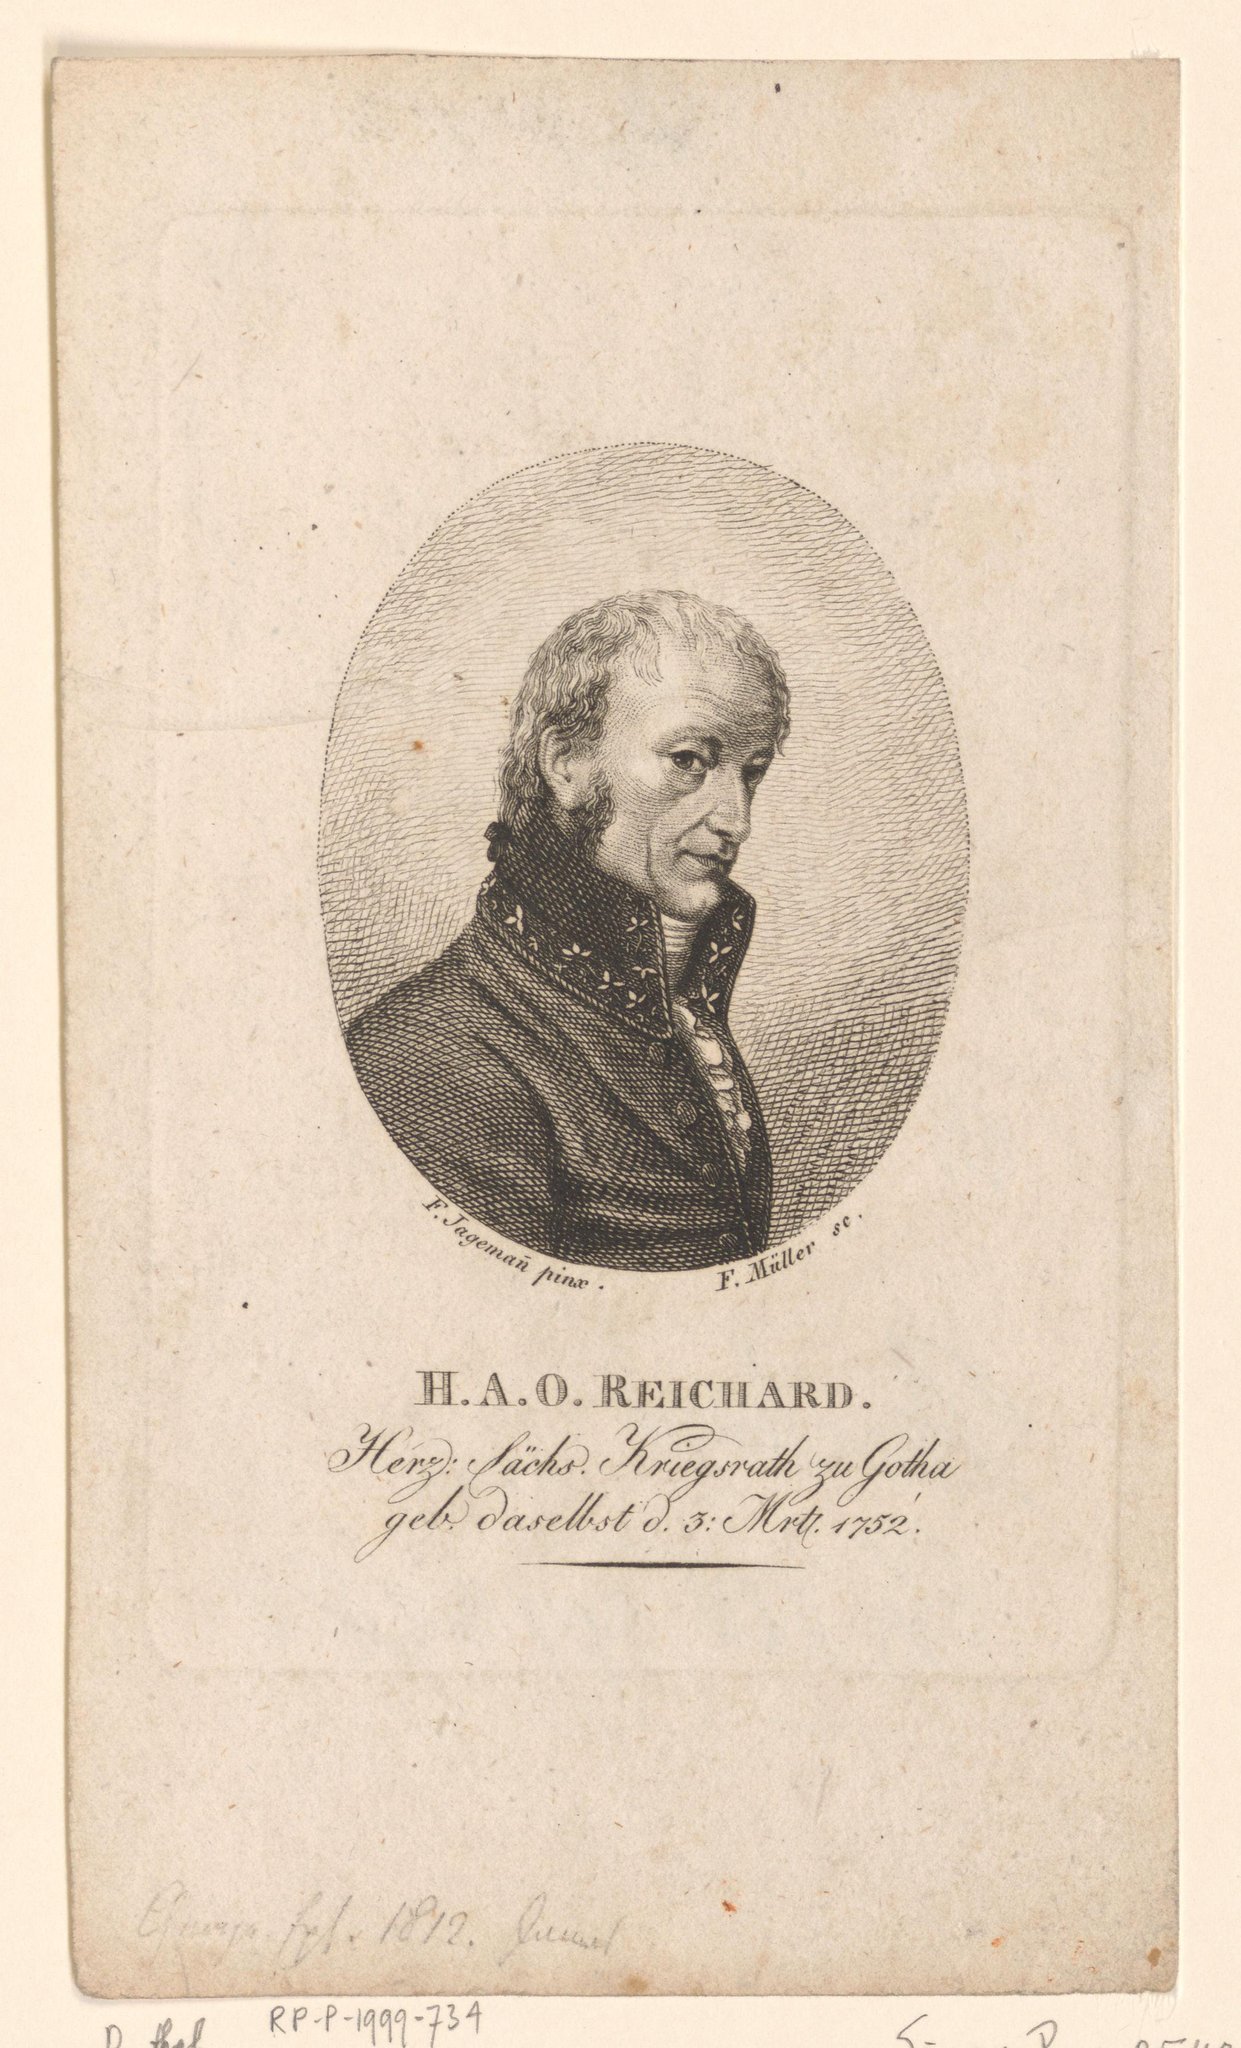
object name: print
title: Portret van Heinrich August Ottokar Reichard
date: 1772-1825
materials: paper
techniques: engraving, etching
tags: historical persons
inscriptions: collector's mark: Lugt 2228